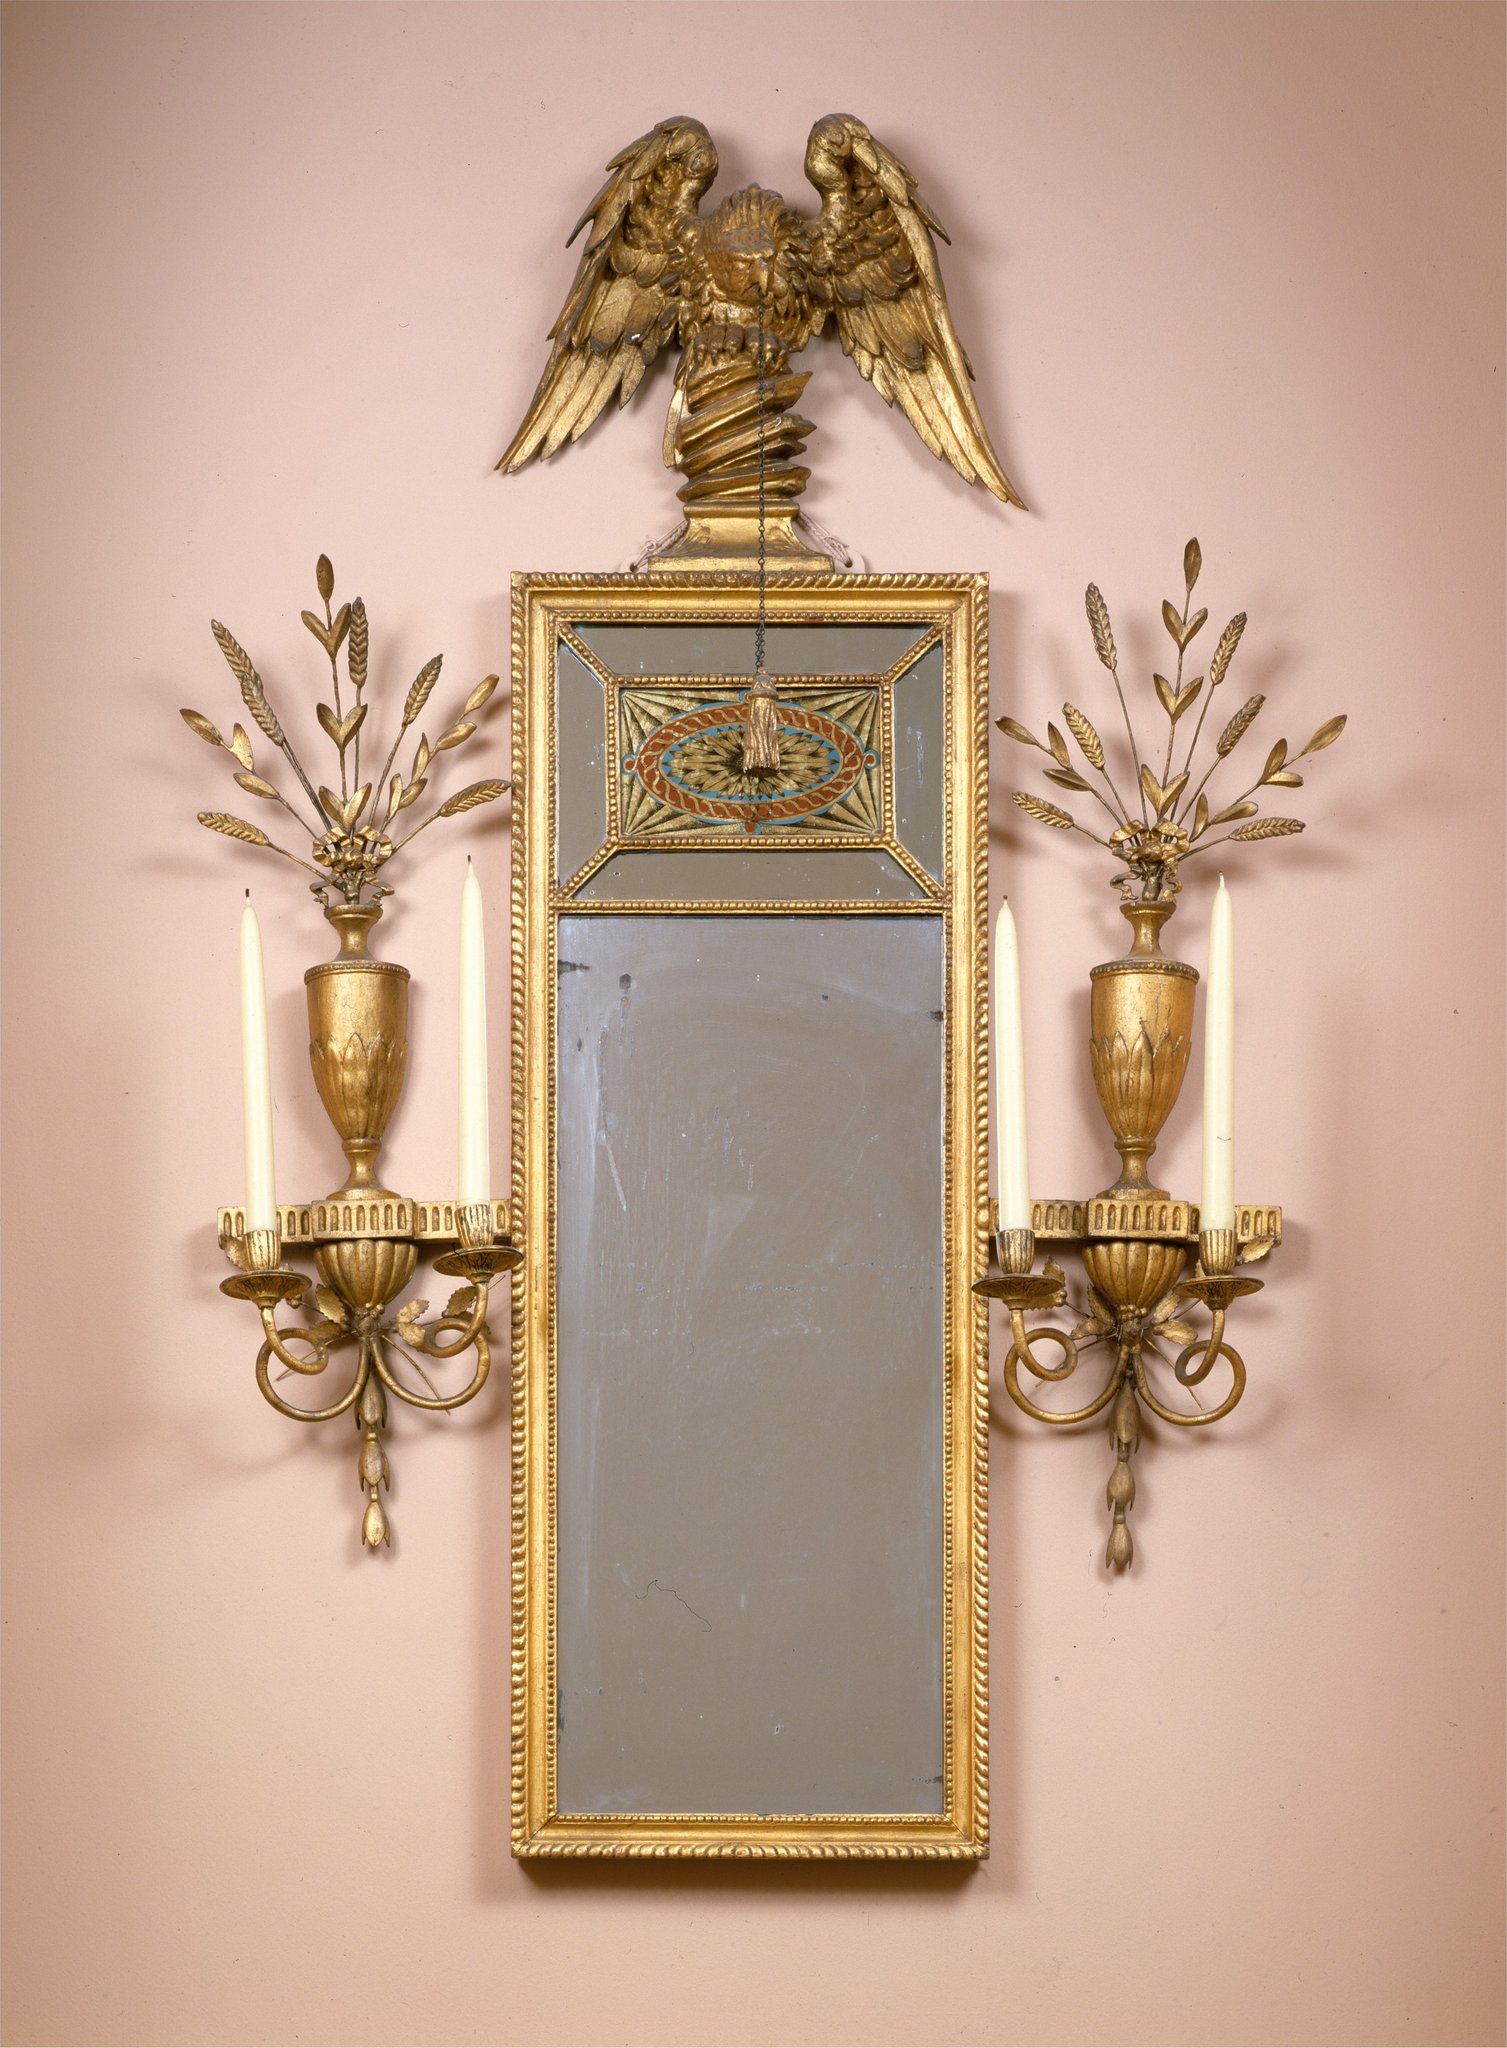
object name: looking glass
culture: american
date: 1795-1810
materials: gesso, wood, metal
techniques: gilding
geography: united states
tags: eagles